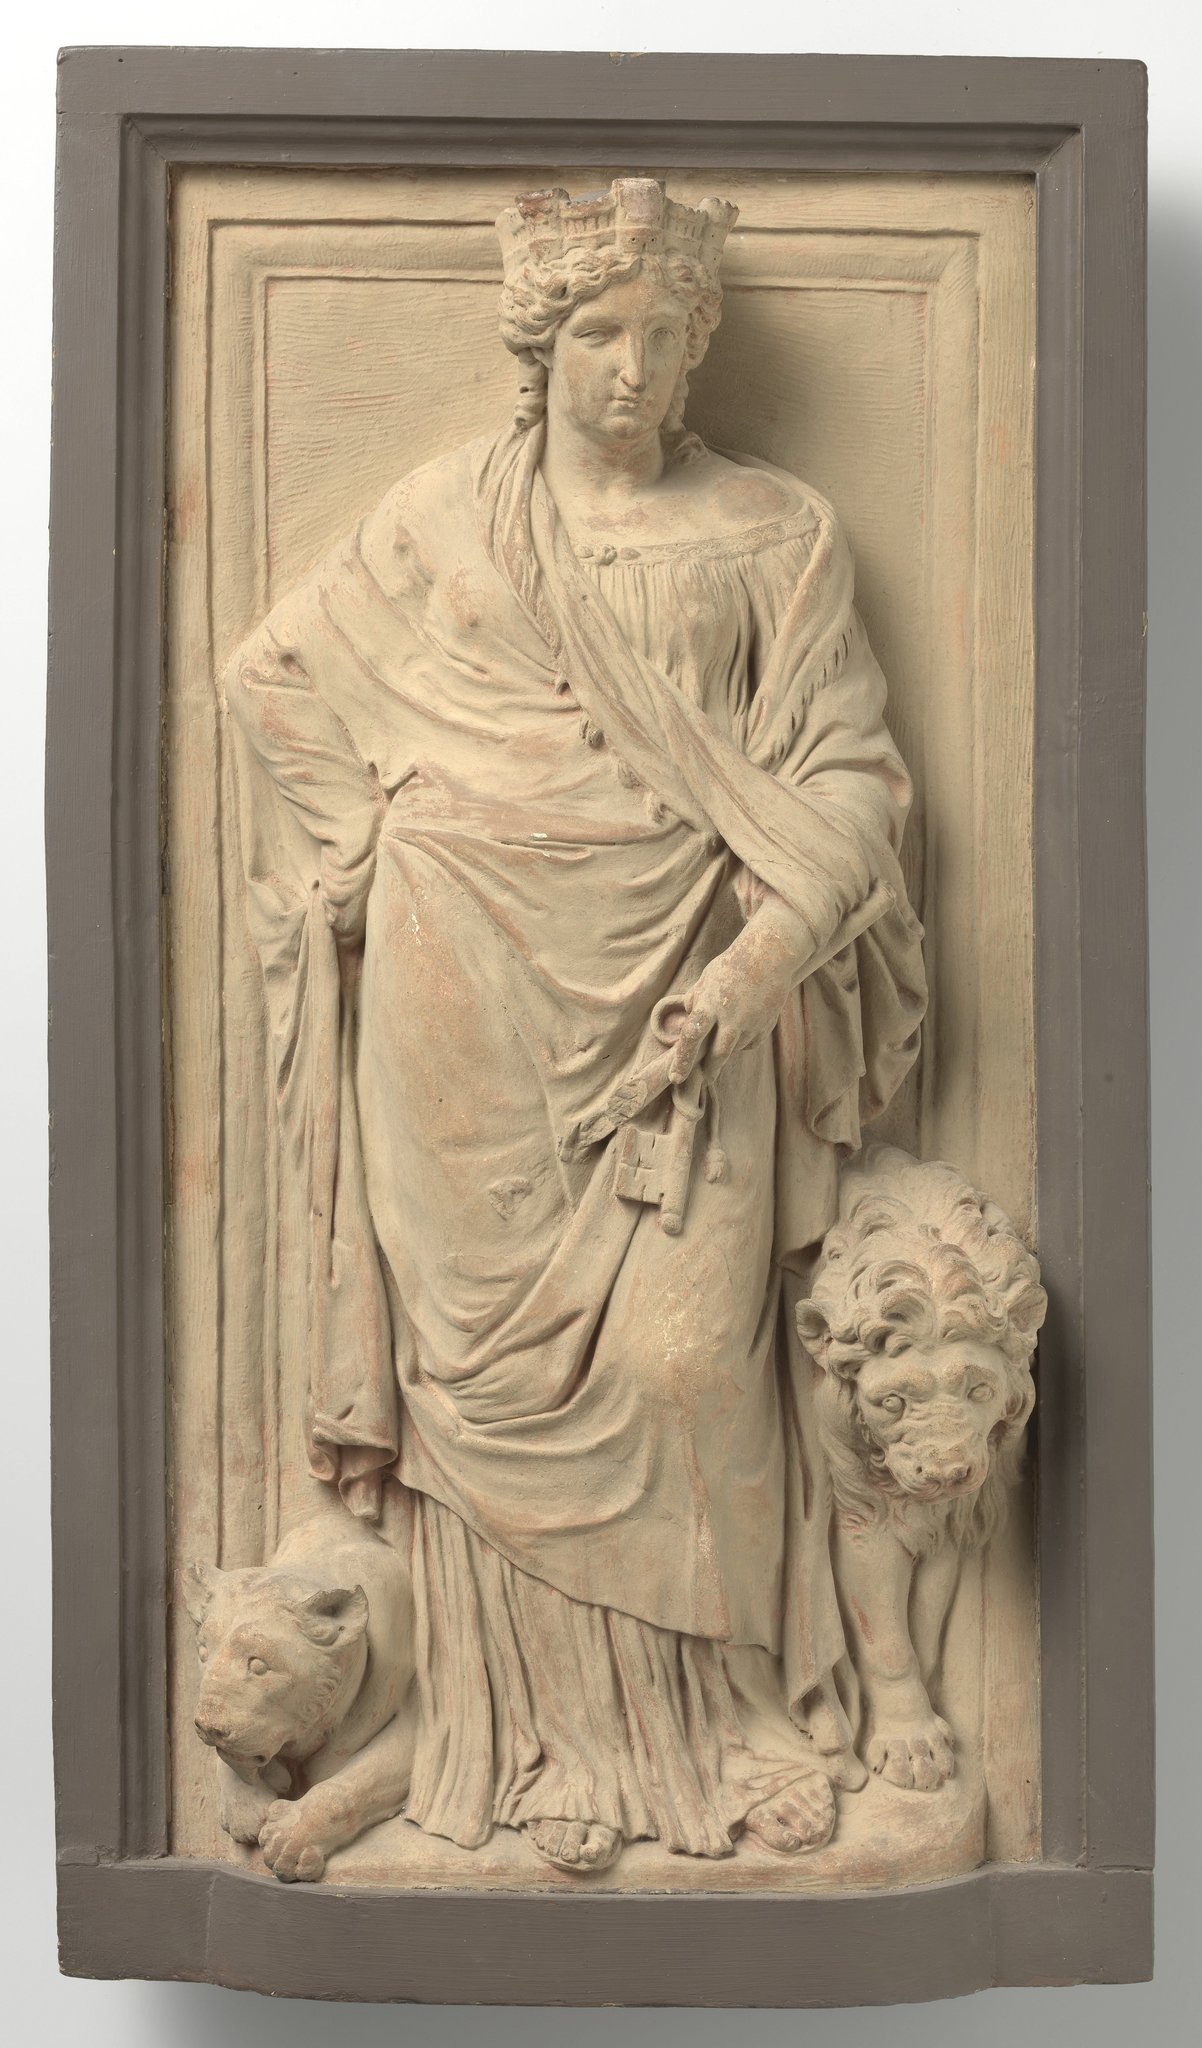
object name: sculpture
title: Cybele, After a Model for a High Relief in the Amsterdam Town Hall (now Royal Palace) at Dam Square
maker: artus quellinus (i)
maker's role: draughtsman, print maker, sculptor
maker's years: 1609-1668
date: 1653-1664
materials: terracotta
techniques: modeling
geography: amsterdam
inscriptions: inscription, on the wooden frame’s reverse, in blue chalk: ‘6’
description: Zij staat frontaal op een vooruitstekend grondje voor een omlijste vlakke achtergrond op het rechterbeen en met het linker gebogen. Zij houdt in de linkerhand de stadssleutel en een bazuin en heeft de rechter in de zij geplaatst met de palm naar buiten. Op het weelderig golvende haar draagt zij de stedekroon; over een fijn geplooid onderkleed, dat tot op de voeten afhangt, een ruime mantel, welke aan de bovenzijde is omgeslagen, waardoor een hermelijnen voering zichtbaar wordt. Deze mantel, die haar gehele rechterschouder en arm bedekt en door de in de mantel gehulde hand wordt opgehouden, valt van de schouder over de borst schuin omlaag en is om de linkerarm geslagen. Aan de voeten sandalen. Rechts van haar staat een leeuw, links ligt een leeuwin.